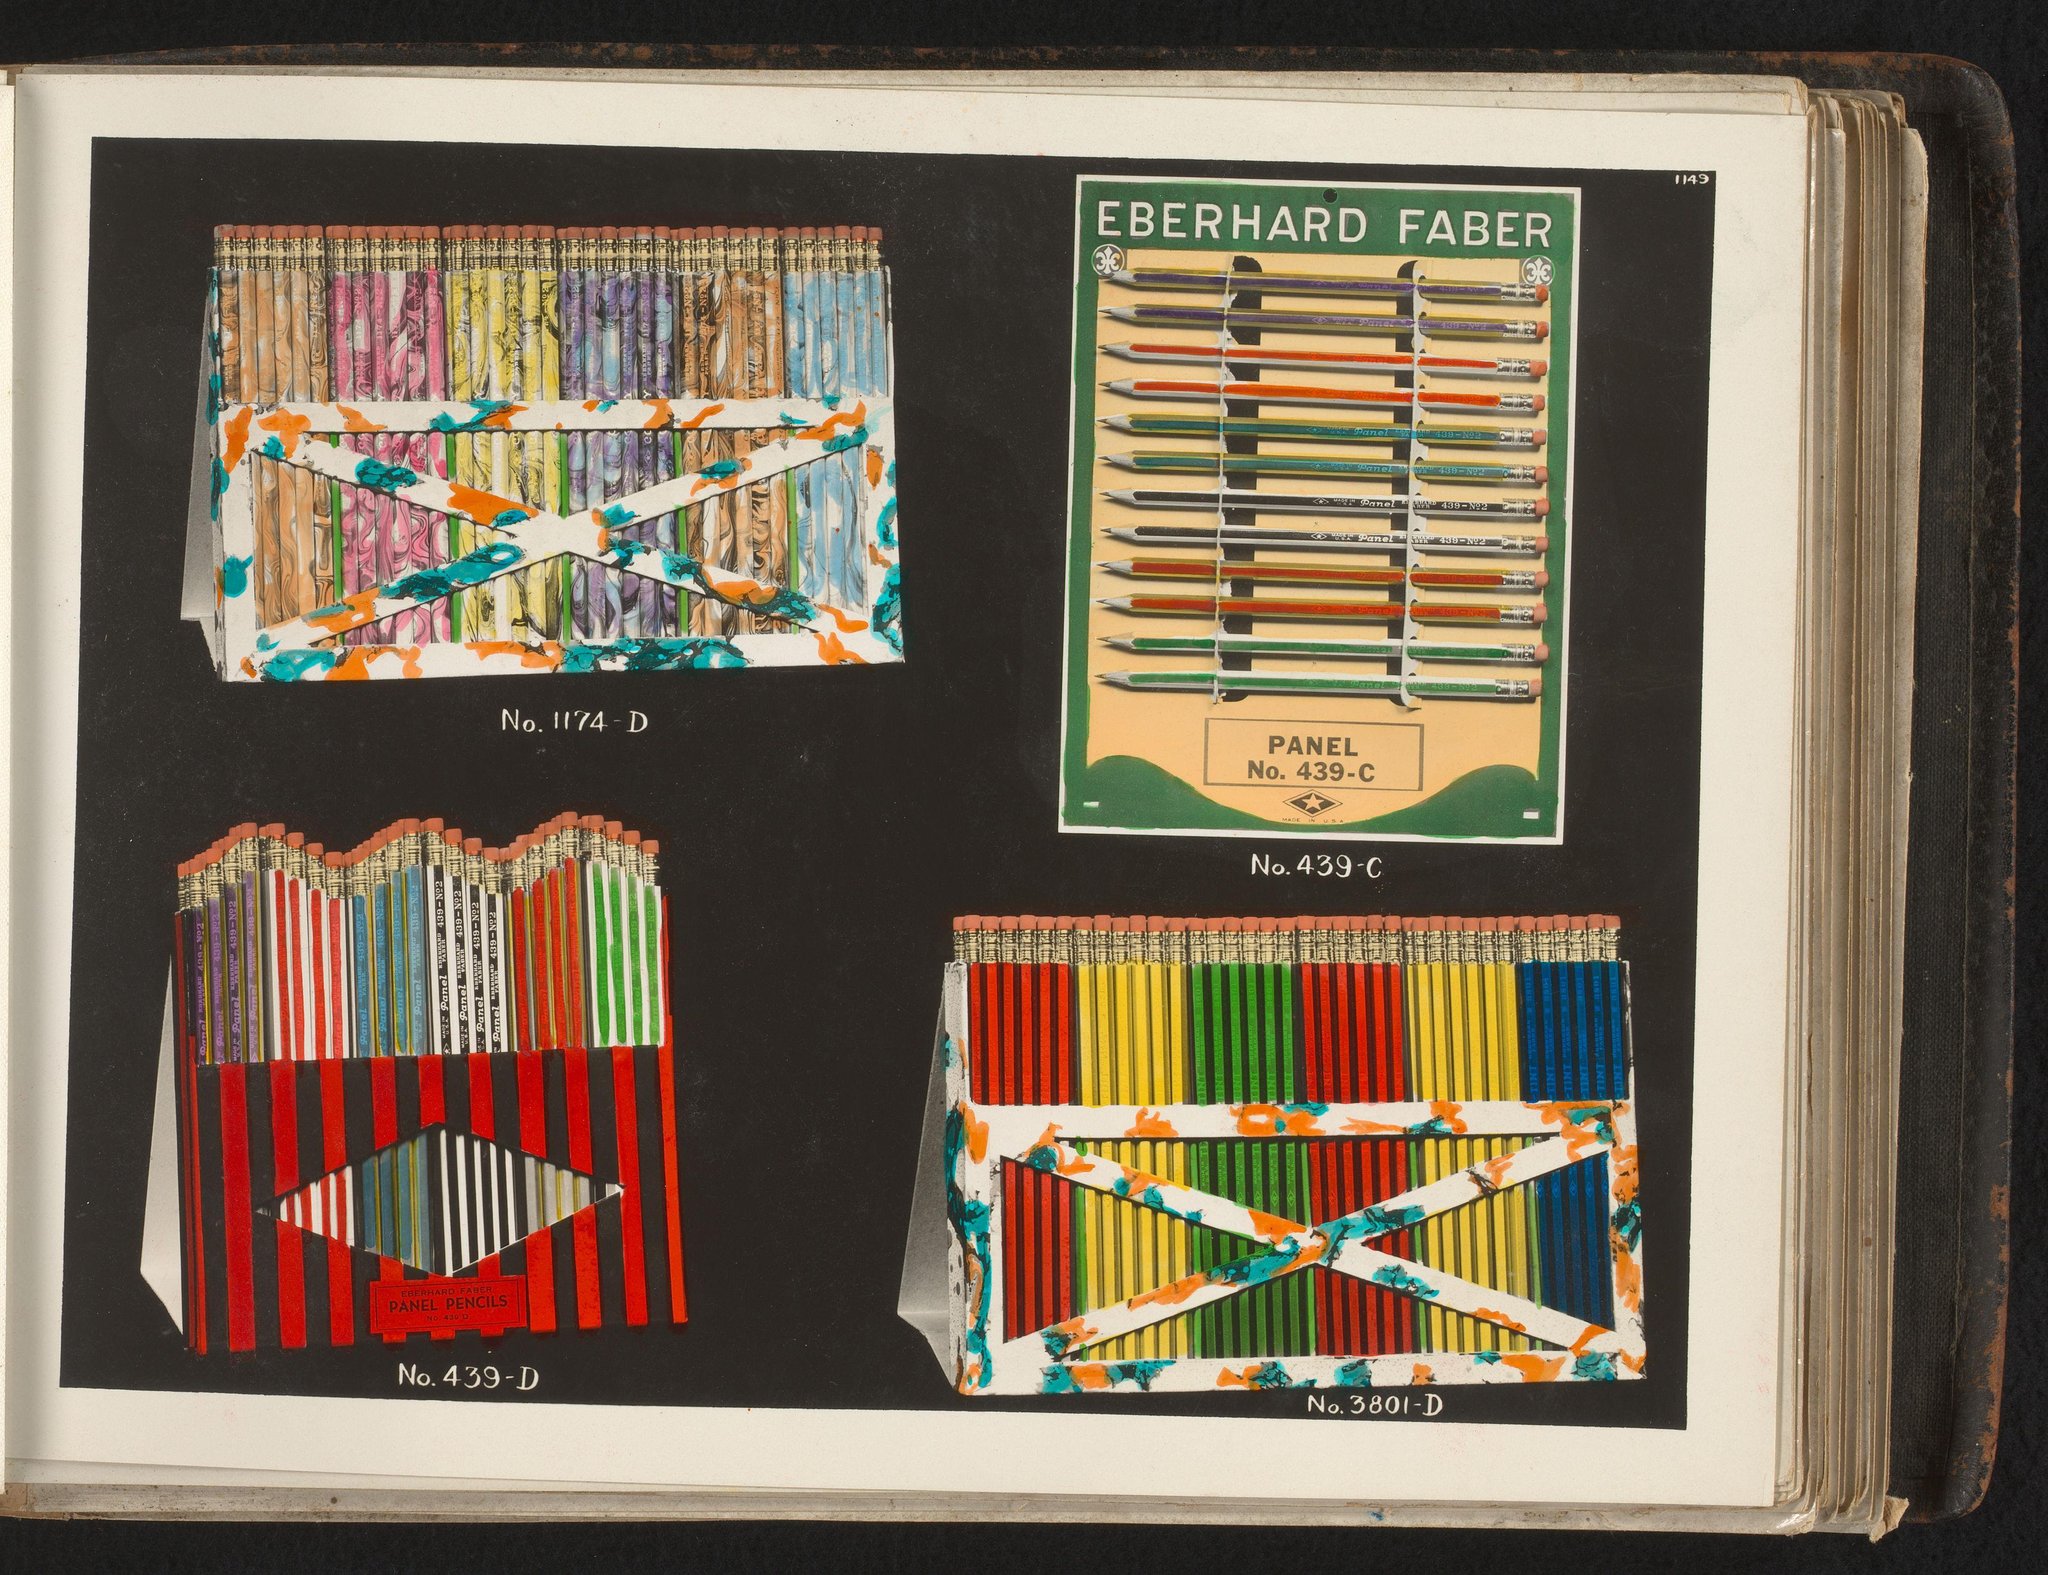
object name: photograph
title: Sets met potloden van Eberhard Faber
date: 1915-1935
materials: paper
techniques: gelatin silver print, hand coloring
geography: springfield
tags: pencil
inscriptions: stamp: ‘Paramount/ Commercial Studios/ 145 Chestnut St./ Springfield - Mass.’, number: ‘1149’